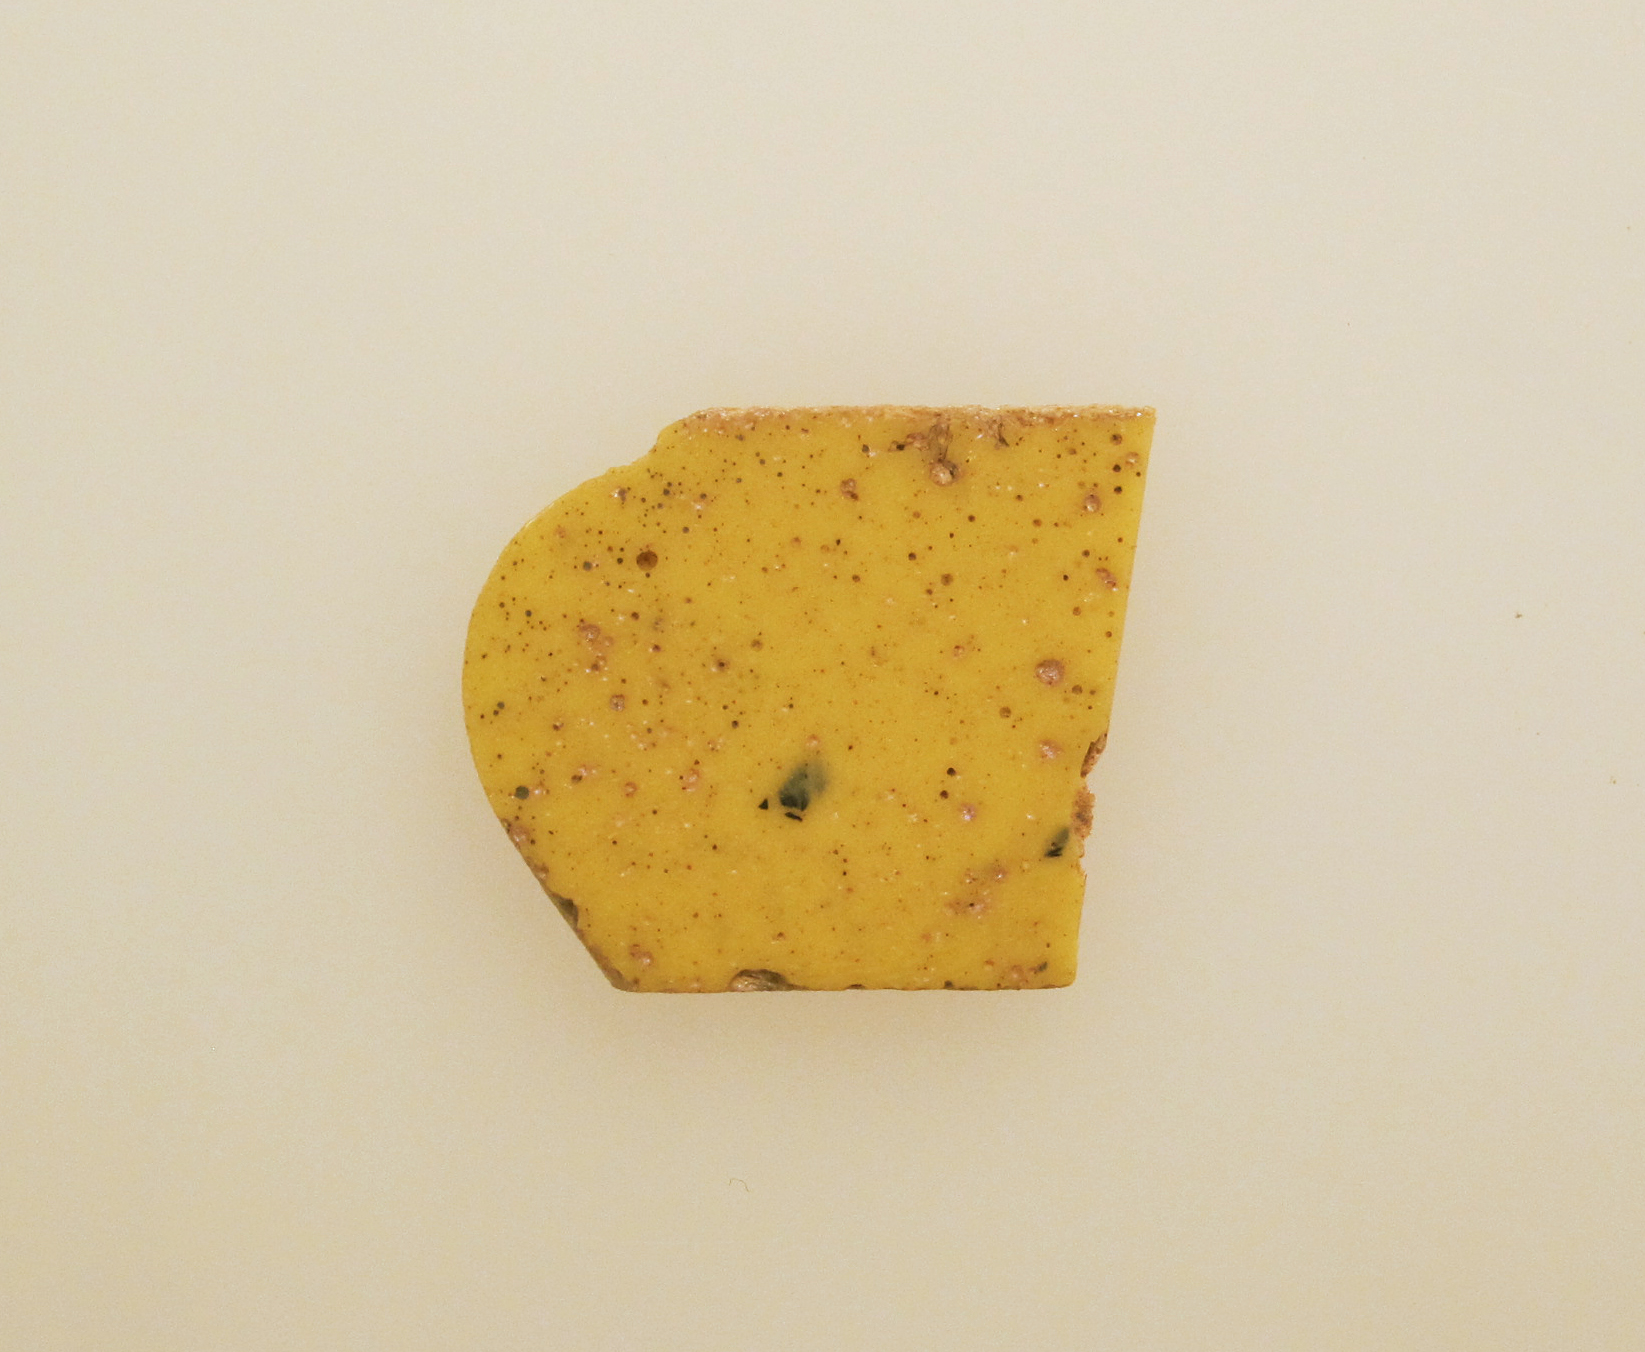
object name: fragment, mosaic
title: Glass mosaic inlay fragment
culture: roman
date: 1-50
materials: glass